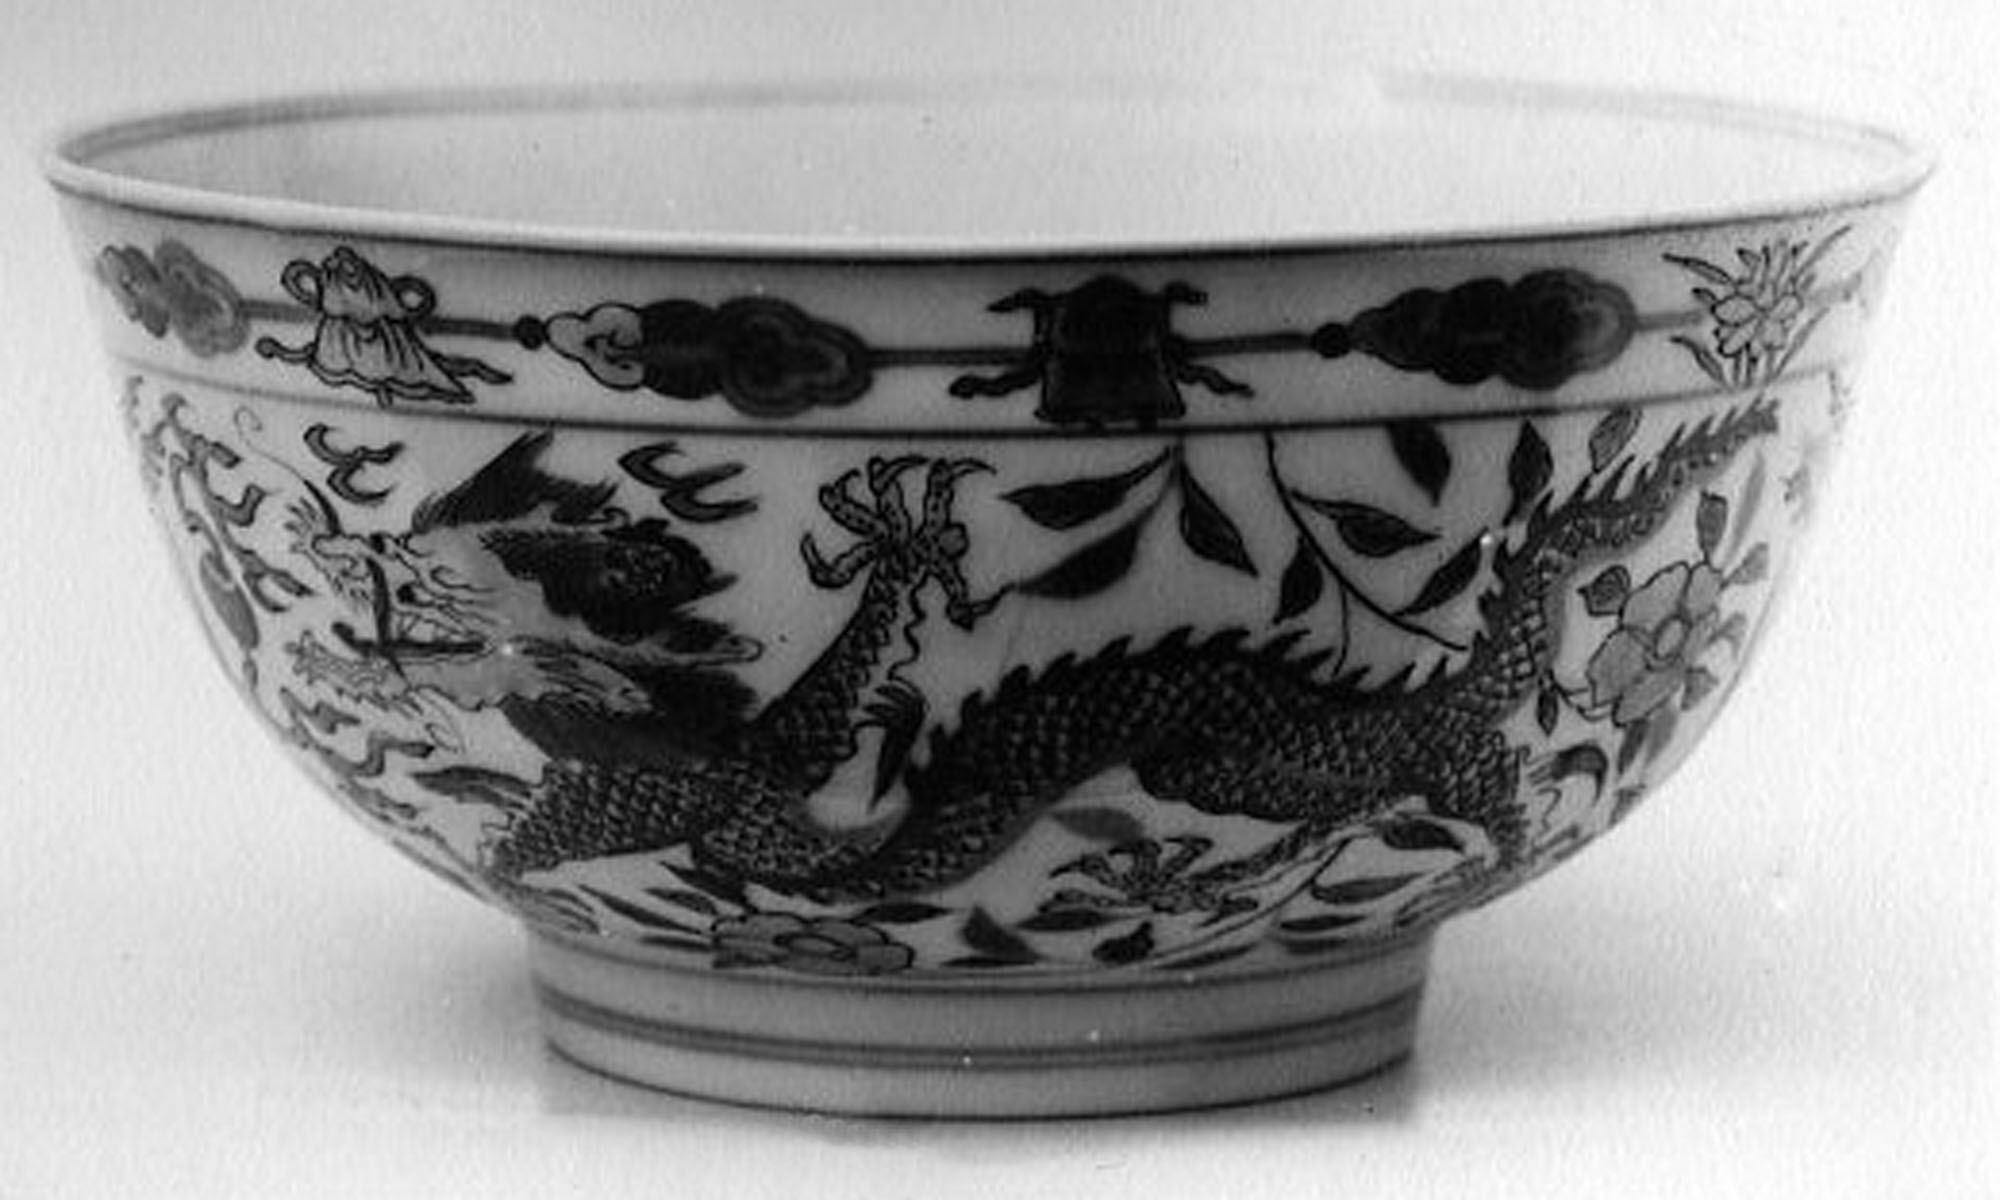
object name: bowl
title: Bowl (one of a pair)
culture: chinese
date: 1662-1722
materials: porcelain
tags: dragons